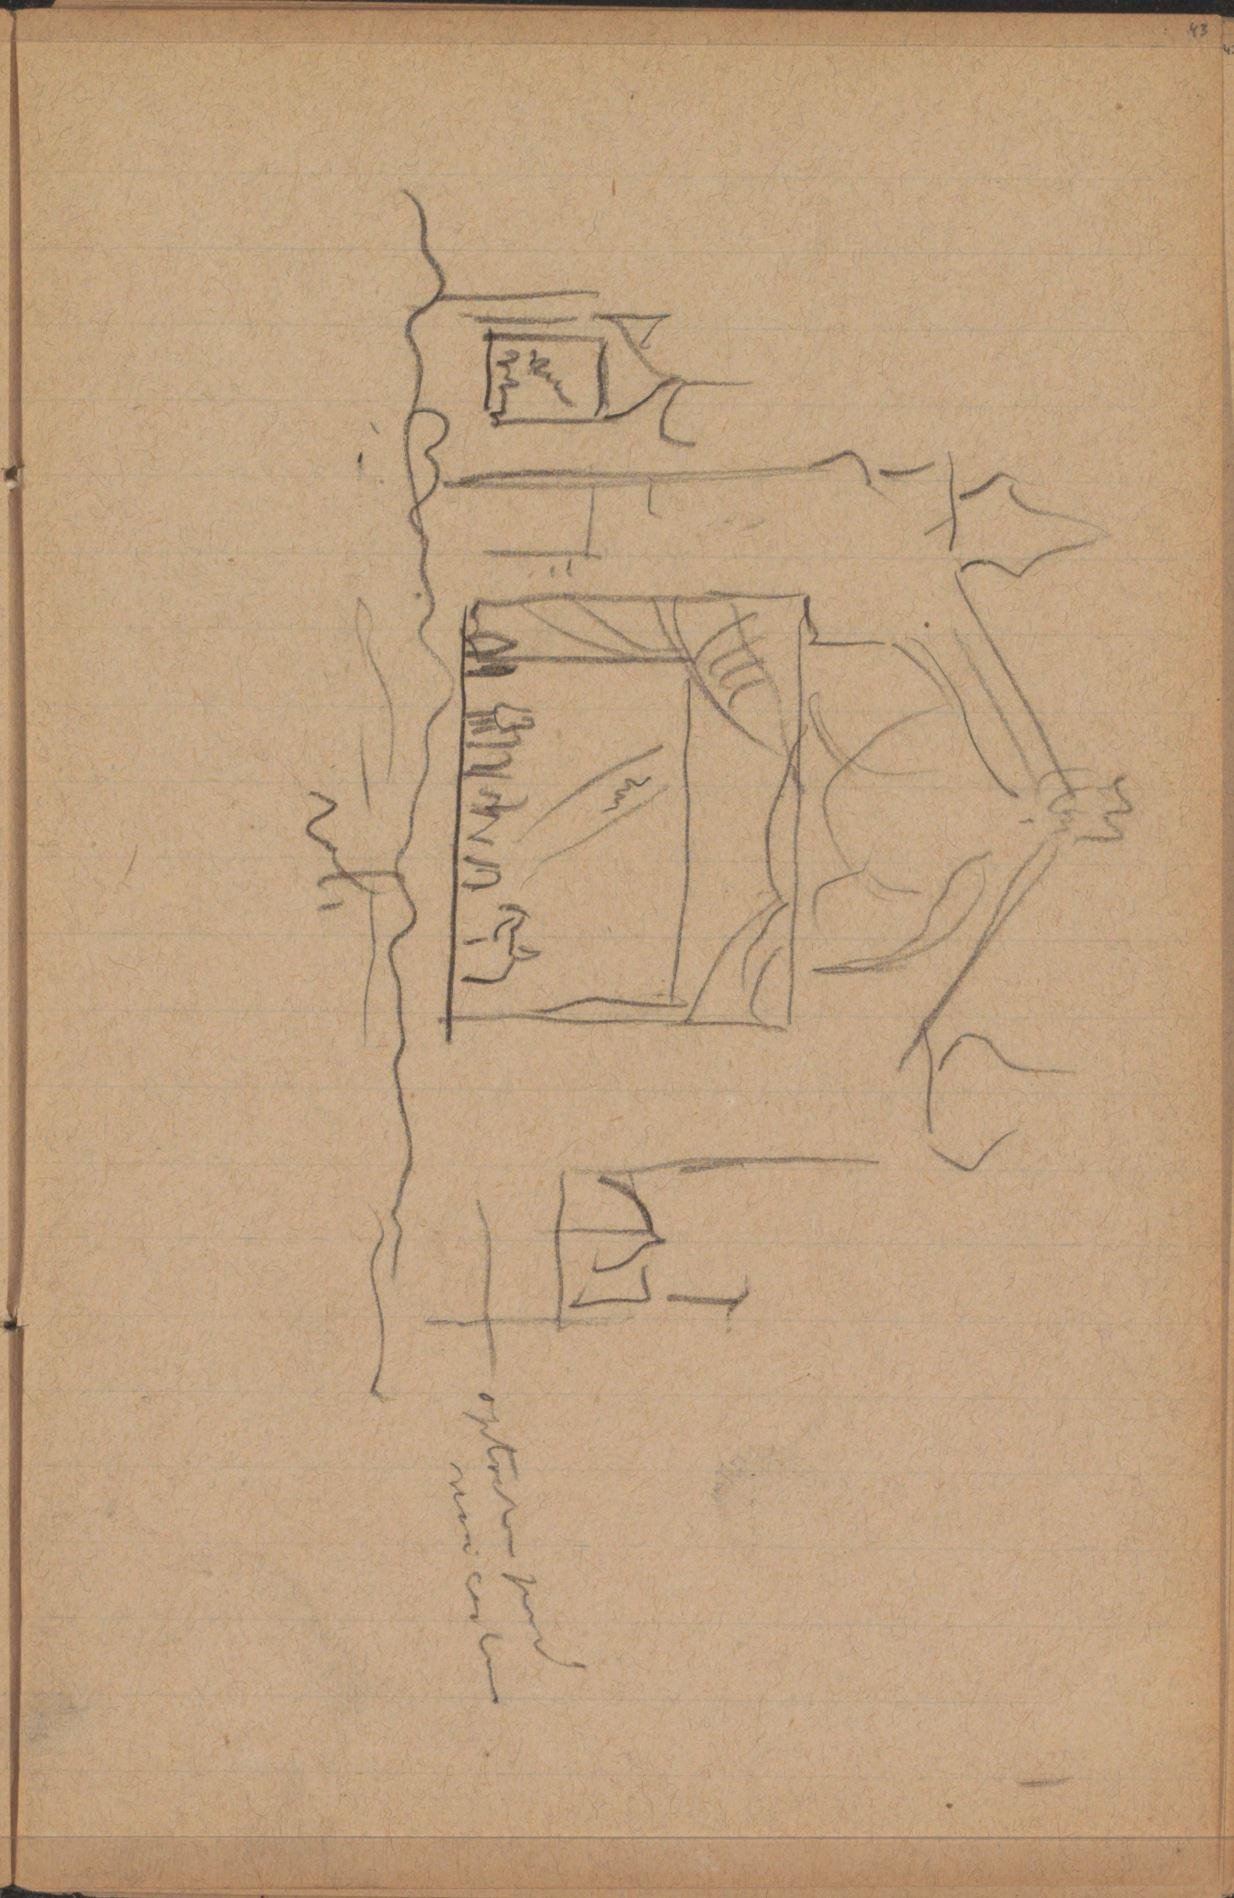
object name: sketchbook leaf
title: Podium van een openluchttheater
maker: marius bauer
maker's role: draughtsman, print maker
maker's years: 1867-1932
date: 1896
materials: chalk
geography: moscow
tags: set, scenery ~ stage, theatre (building)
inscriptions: kleurnotitie, handgeschreven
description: Pagina 43 uit een schetsboek met 50 bladen.